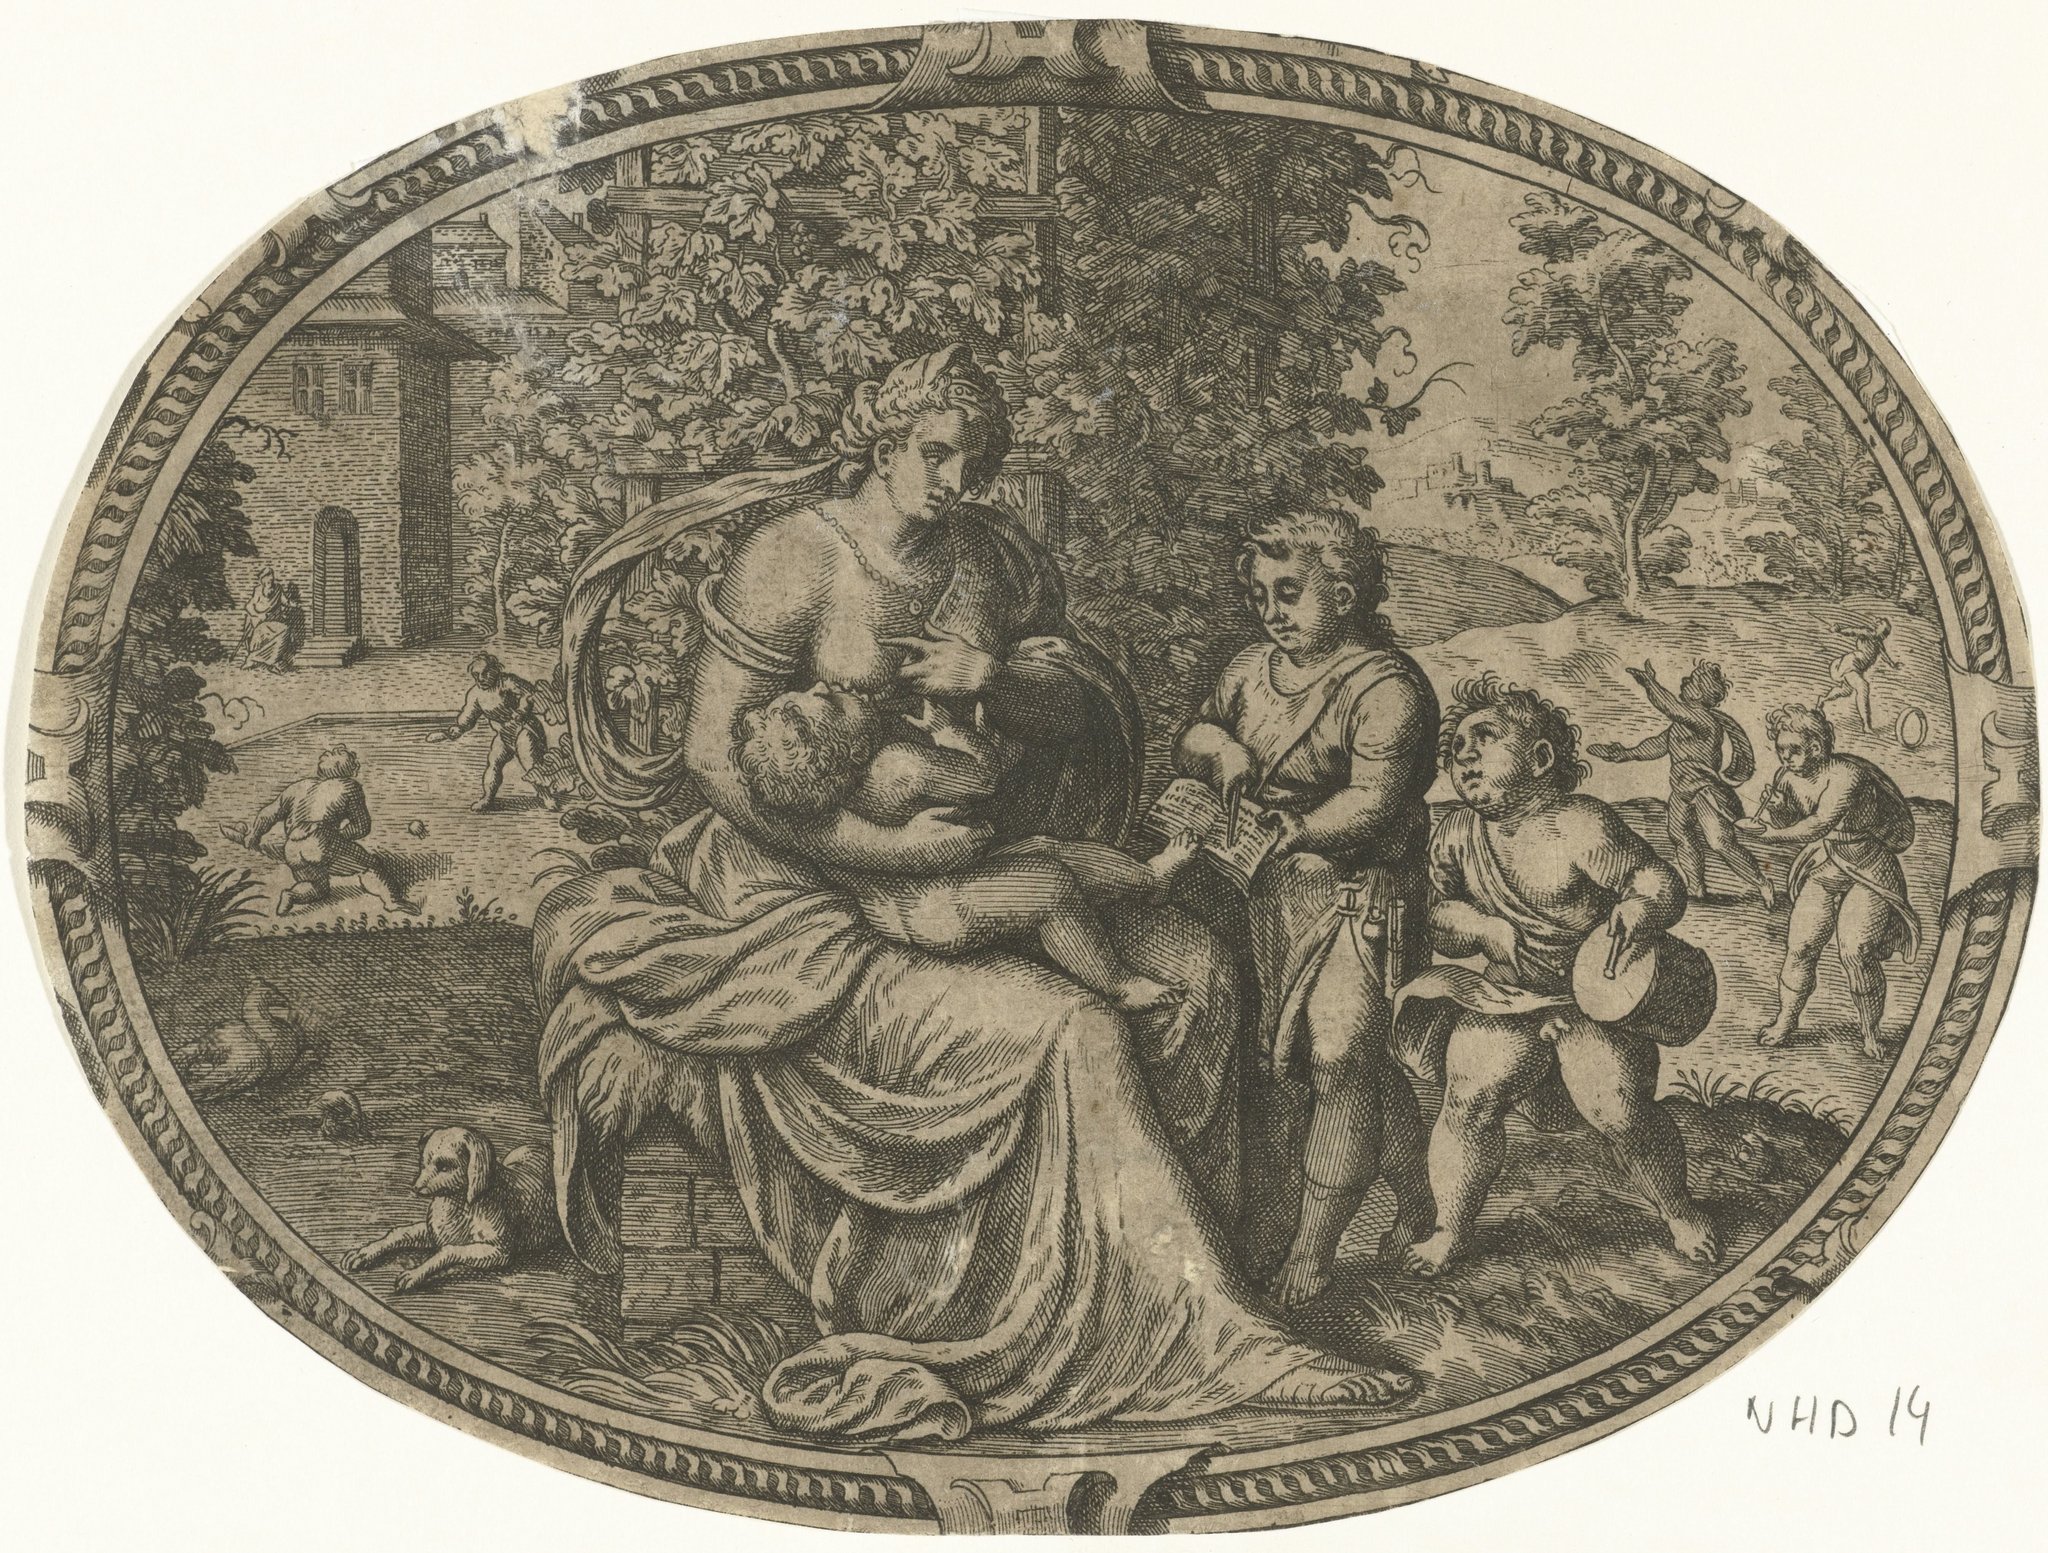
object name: print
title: Tien leeftijden van de mens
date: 1569-1575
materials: paper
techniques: engraving, etching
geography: antwerp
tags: children's games and plays, nursing, suckling, the first years ~ the ages of man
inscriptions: collector's mark: Lugt 2228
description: In een ovaal kader versierd met ornamenten een voorstelling van een moeder die haar kind de borst geeft. Naast haar twee andere kinderen. Een van hen laat haar iets lezen uit een boek, terwijl de andere op een trommel slaat. In de achtergrond spelen kinderen spelletjes. De prent heeft een Latijns onderschrift.